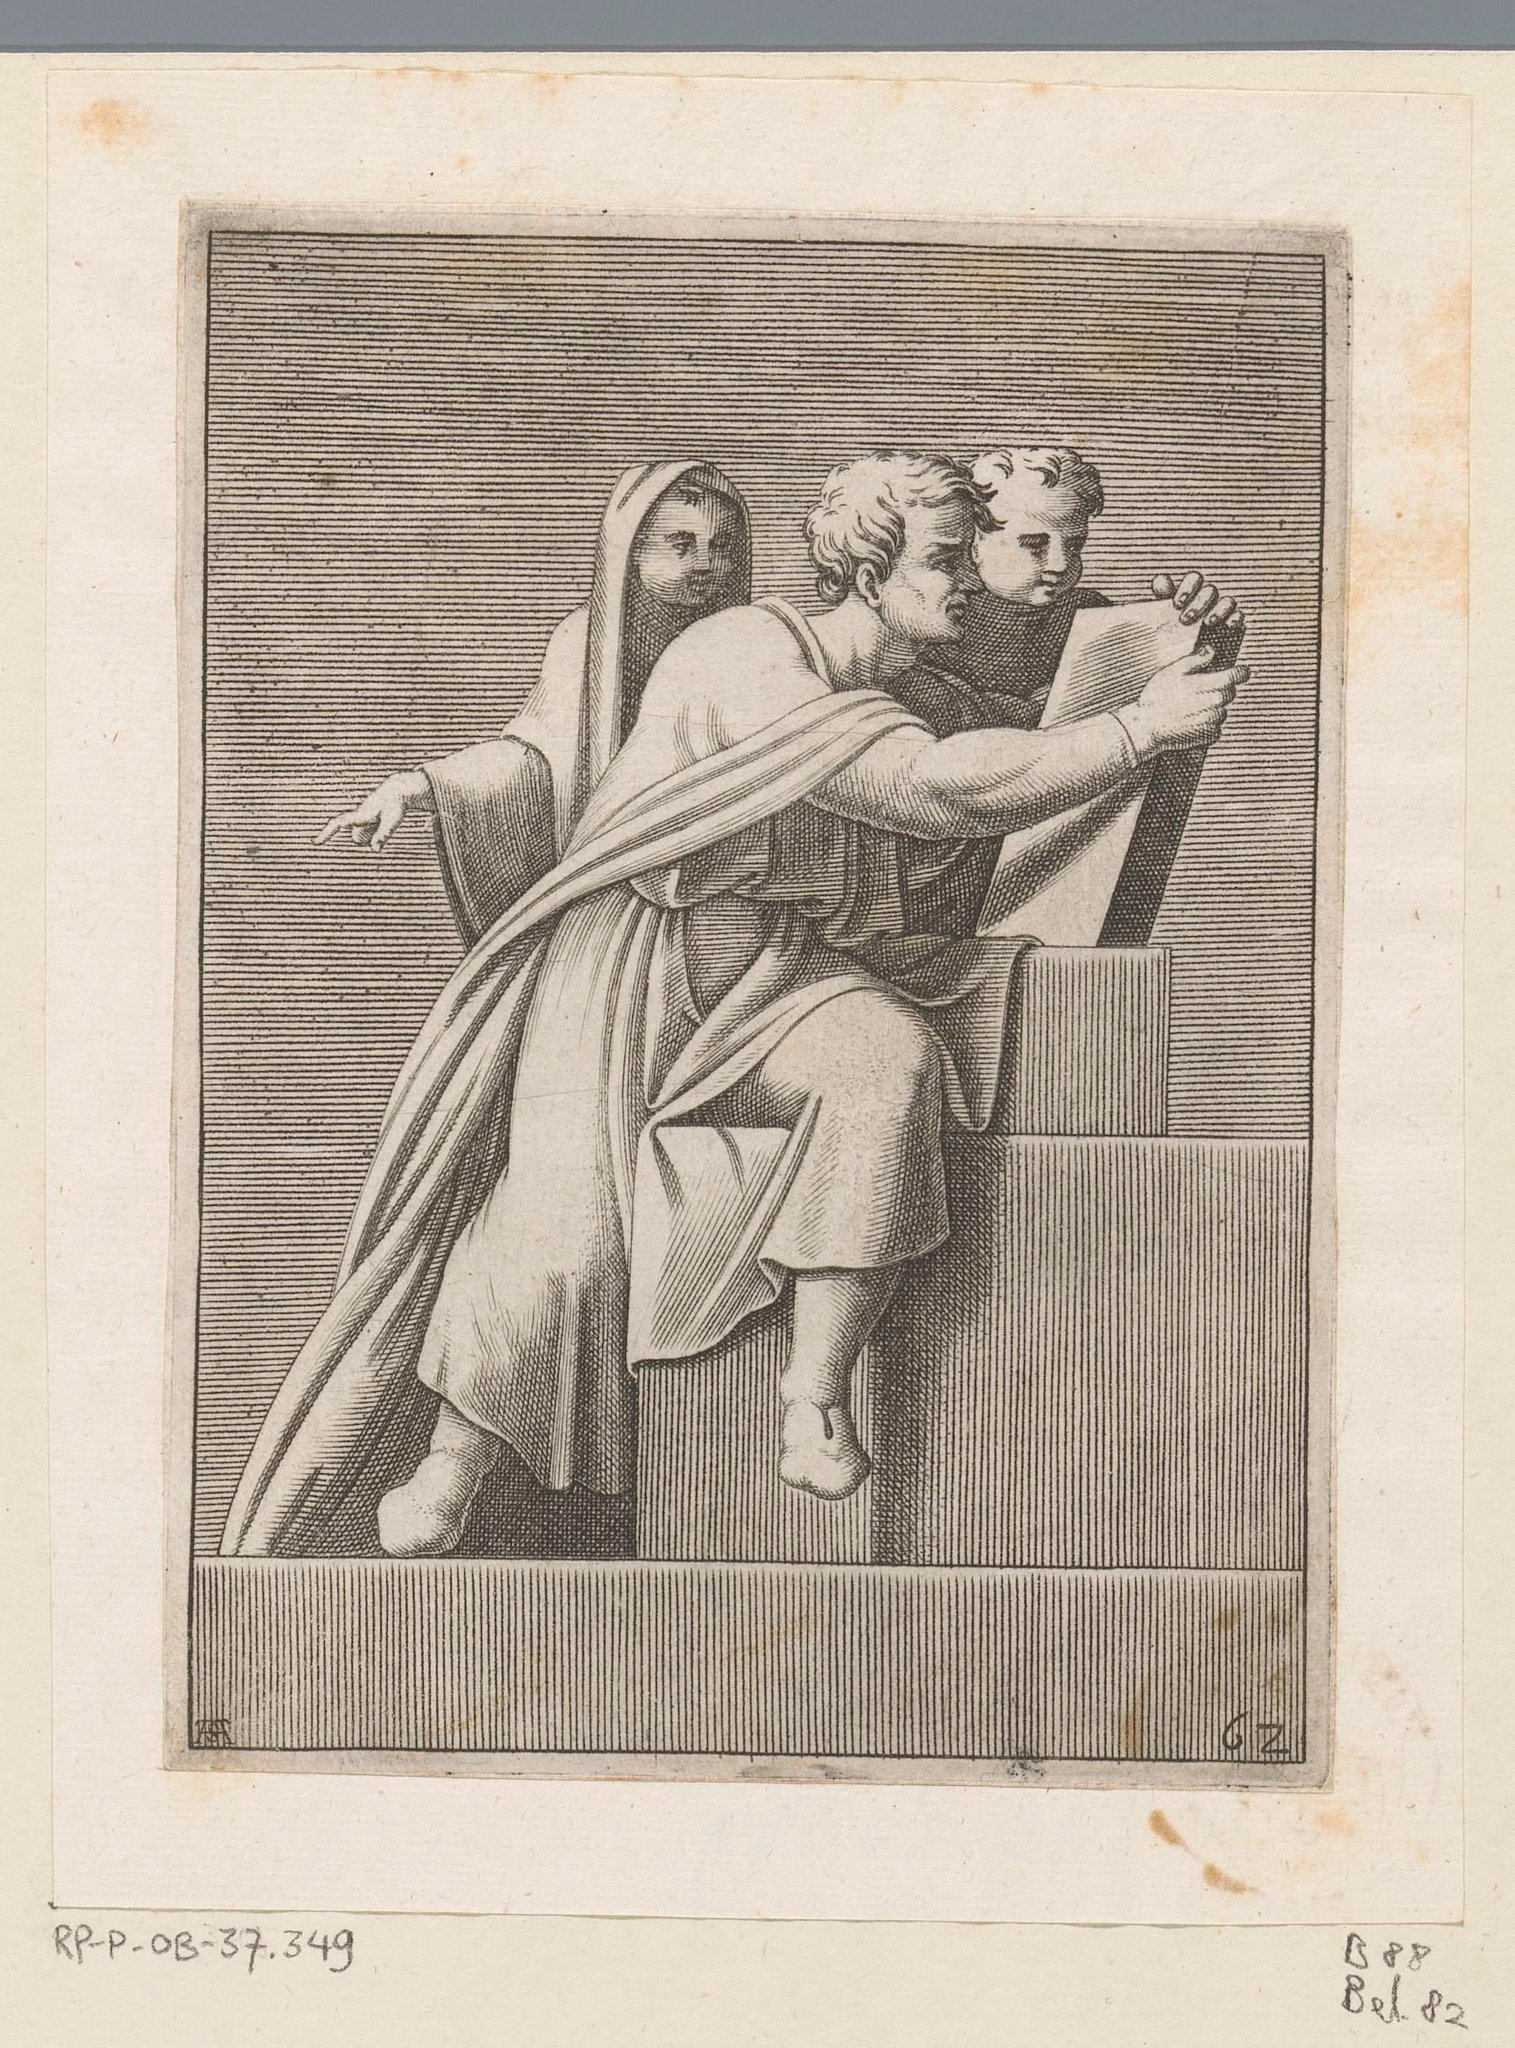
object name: print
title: Man met een schrijftablet en twee kinderen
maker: adamo scultori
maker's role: painter, print maker, sculptor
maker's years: 1530-1585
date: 1585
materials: paper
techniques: engraving, intaglio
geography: italy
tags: writing tablets, father and child(ren), man and child(ren) (family group)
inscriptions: collector's mark: Lugt 240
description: Deze prent maakt deel uit van een serie bestaande uit een titelprent en 72 prenten naar schilderingen door Michelangelo in de Sixtijnse Kapel in het Vaticaan.